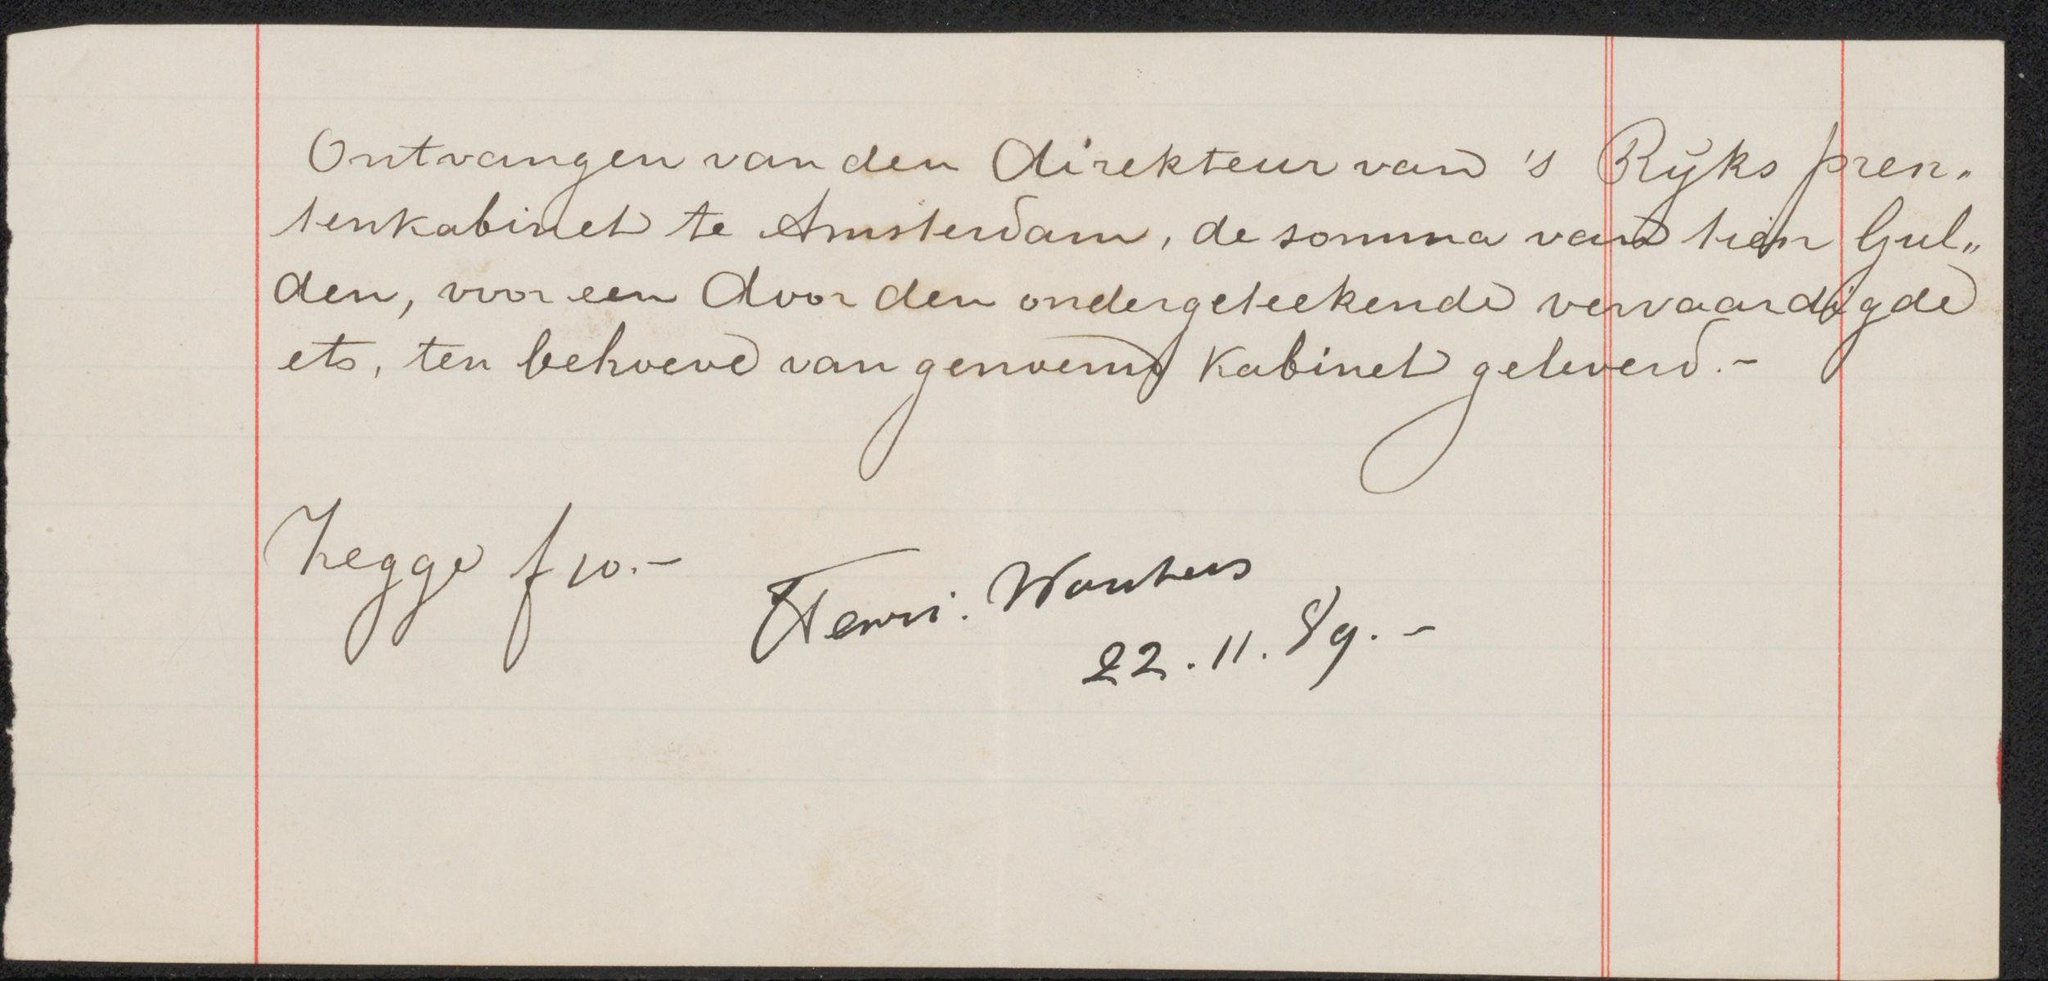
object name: ontvangstbewijs, kwitantie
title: Kwitantie voor Johan Philip van der Kellen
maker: henri wouters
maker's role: draughtsman, print maker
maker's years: 1866-1935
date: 1889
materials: ink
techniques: pen, writing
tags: print room, utrecht, print maker, draughtsman, johan philip van der kellen, the graphic arts, art collecting, money